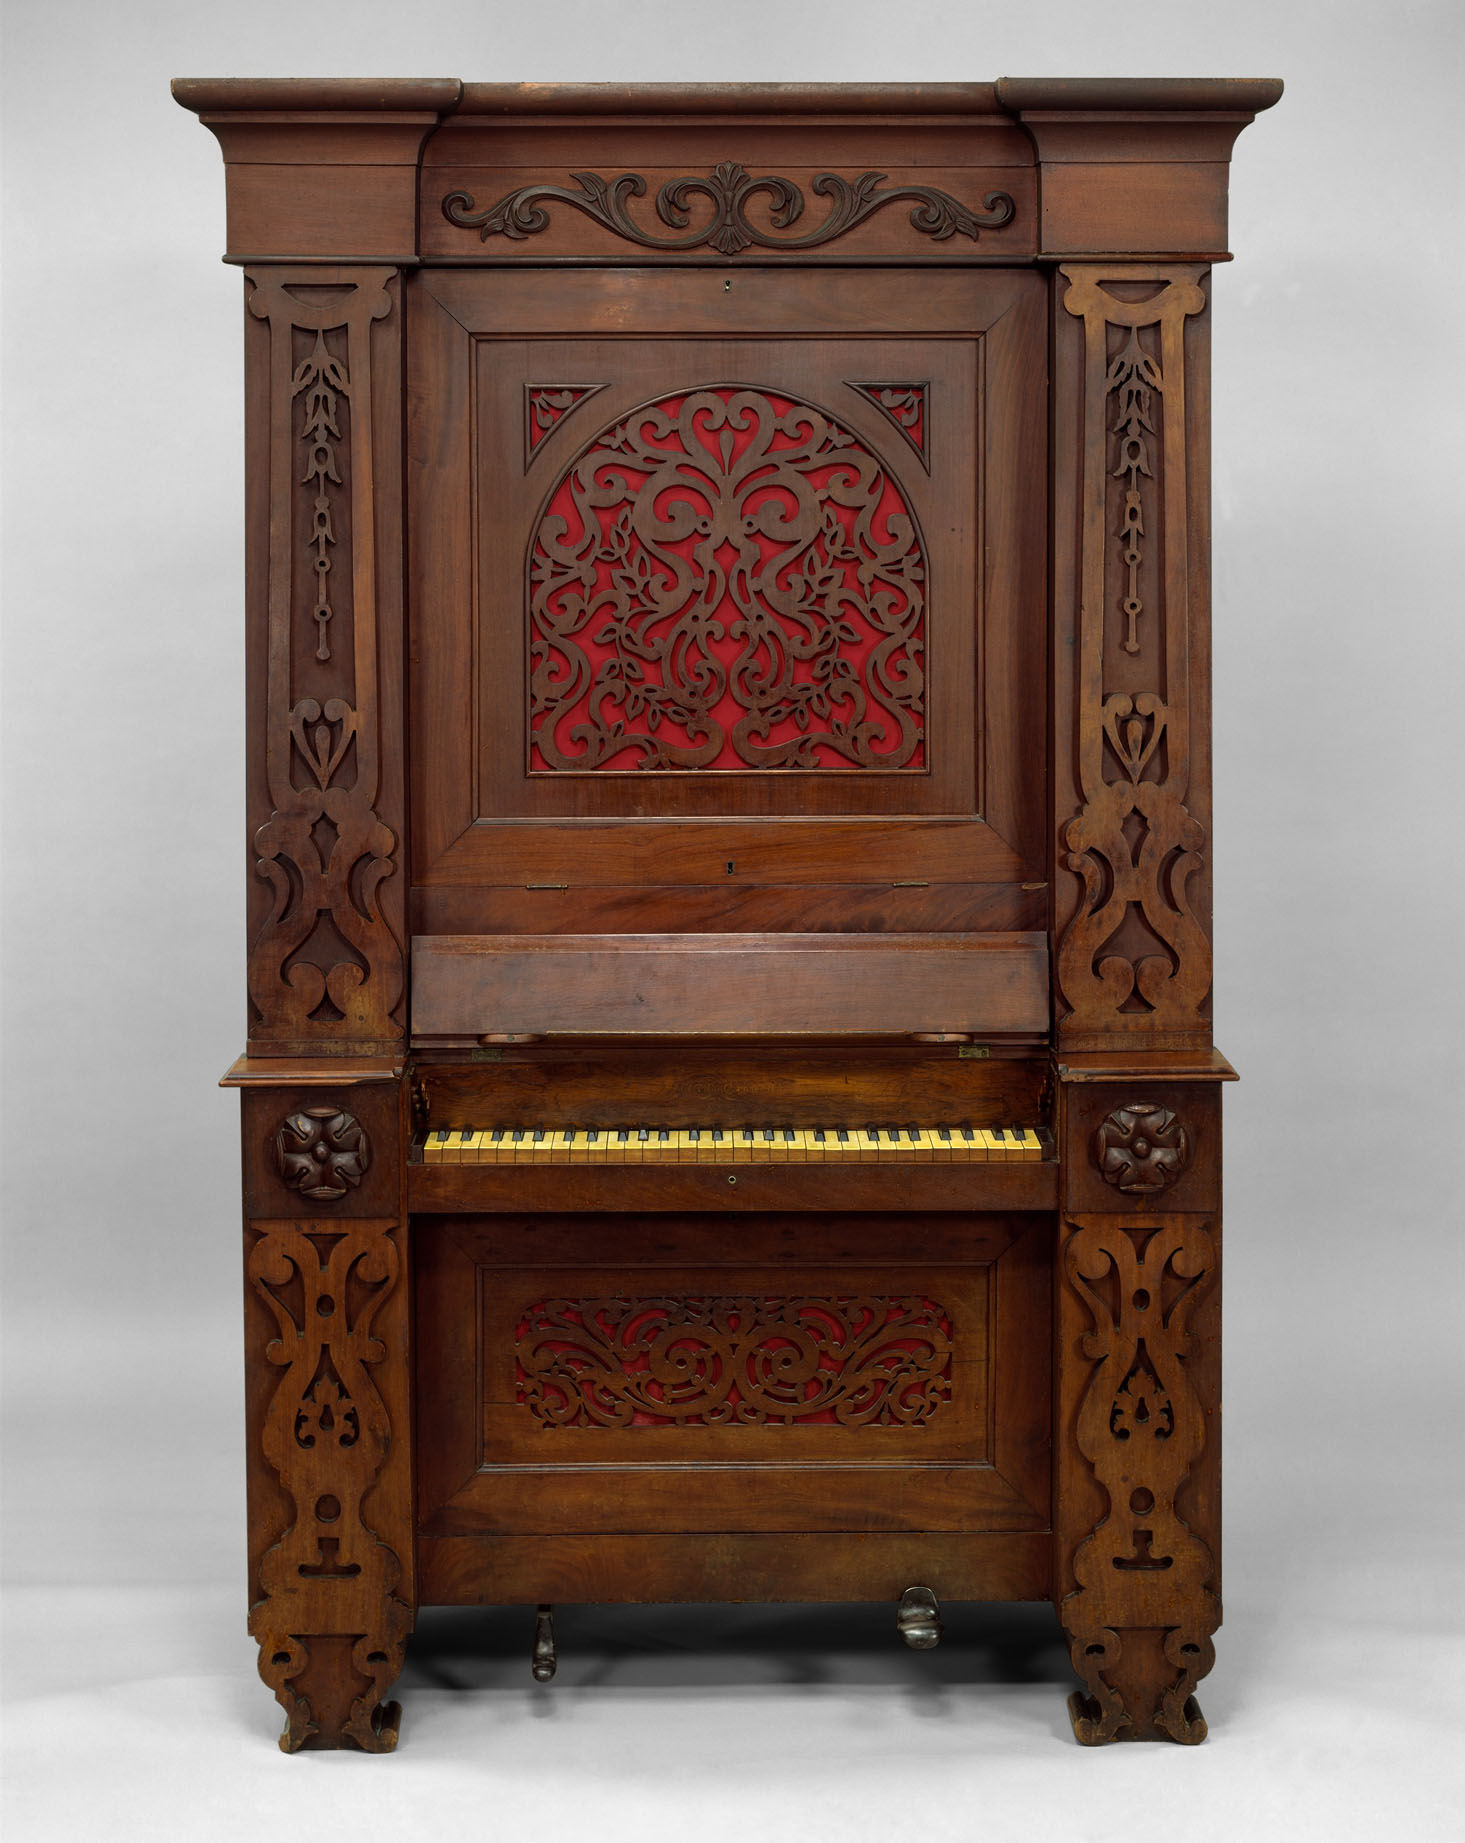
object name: chamber organ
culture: american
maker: william crowell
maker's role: maker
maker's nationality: american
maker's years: 1830-1852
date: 1852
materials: wood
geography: united states